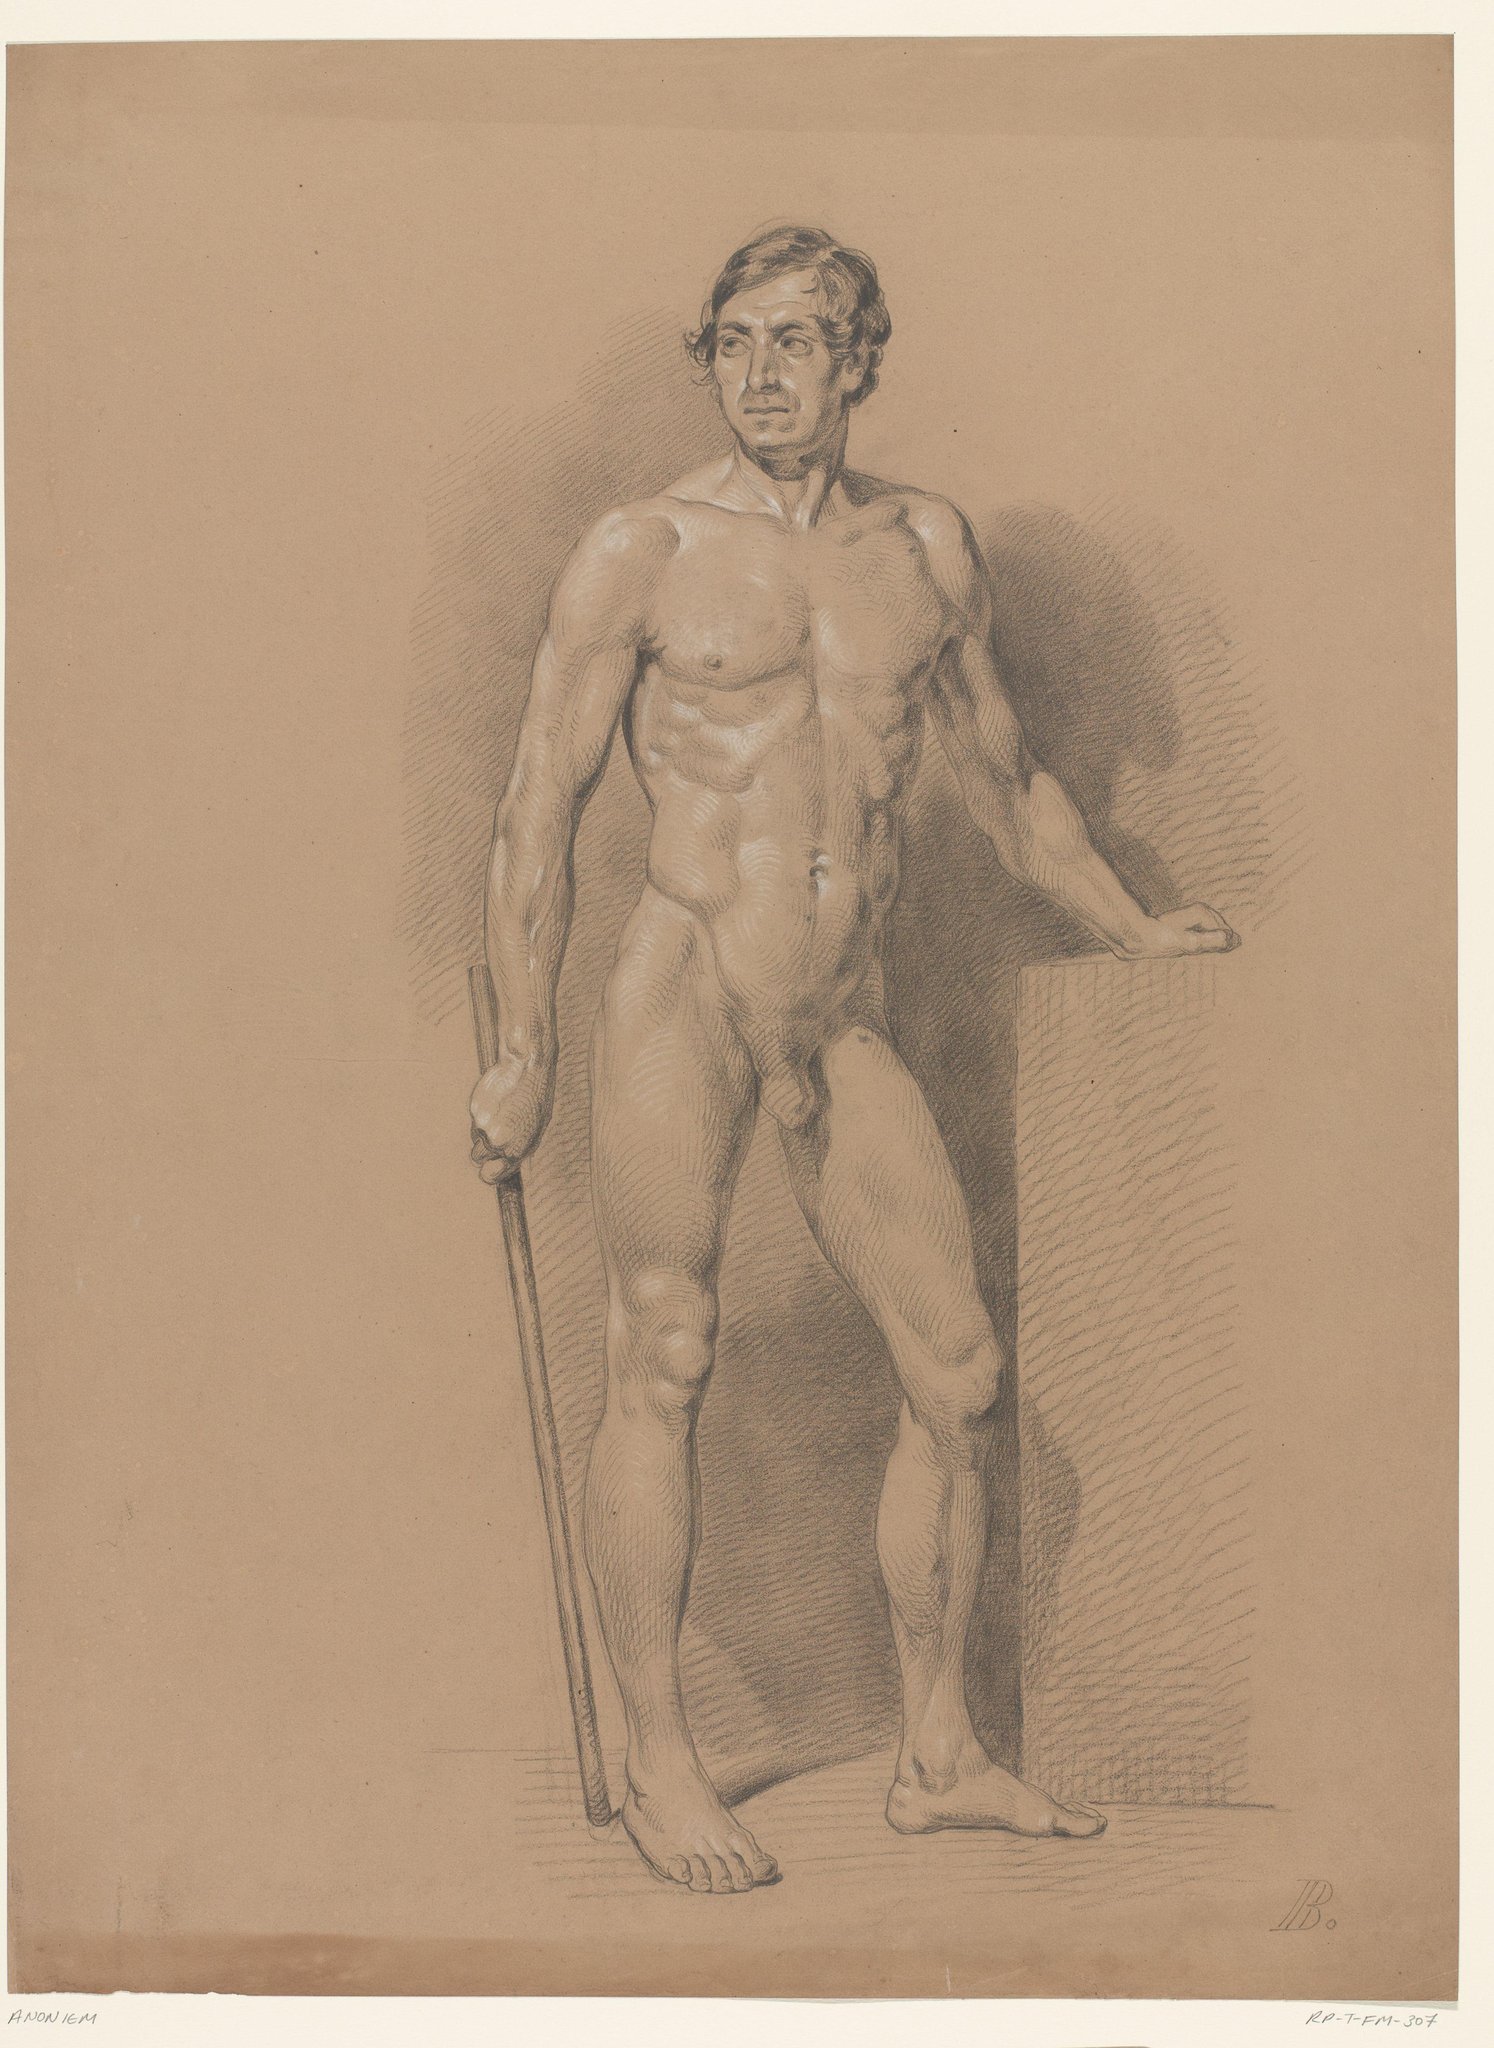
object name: drawing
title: Staand mannelijk naakt met een stok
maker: Anonymous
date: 1800-1900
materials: chalk, paper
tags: standing figure